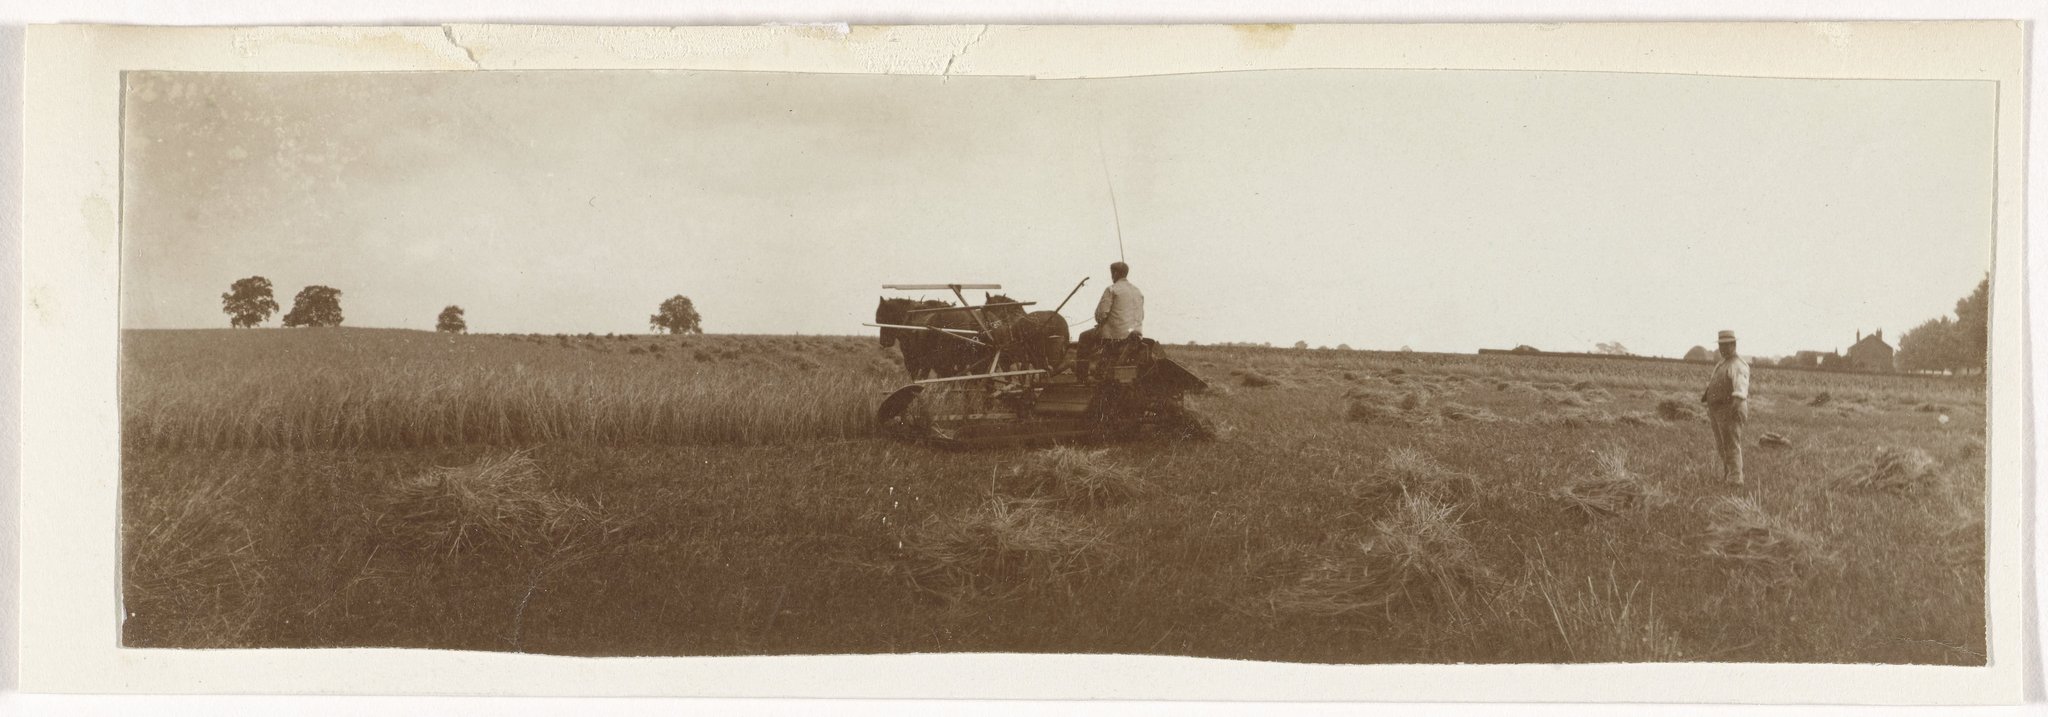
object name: panoramic photograph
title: Boer met ploeg en een span paarden in Groot-Brittannië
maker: Anonymous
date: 1900-1915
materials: paper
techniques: albumen print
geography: great britain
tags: agricultural implements: plough